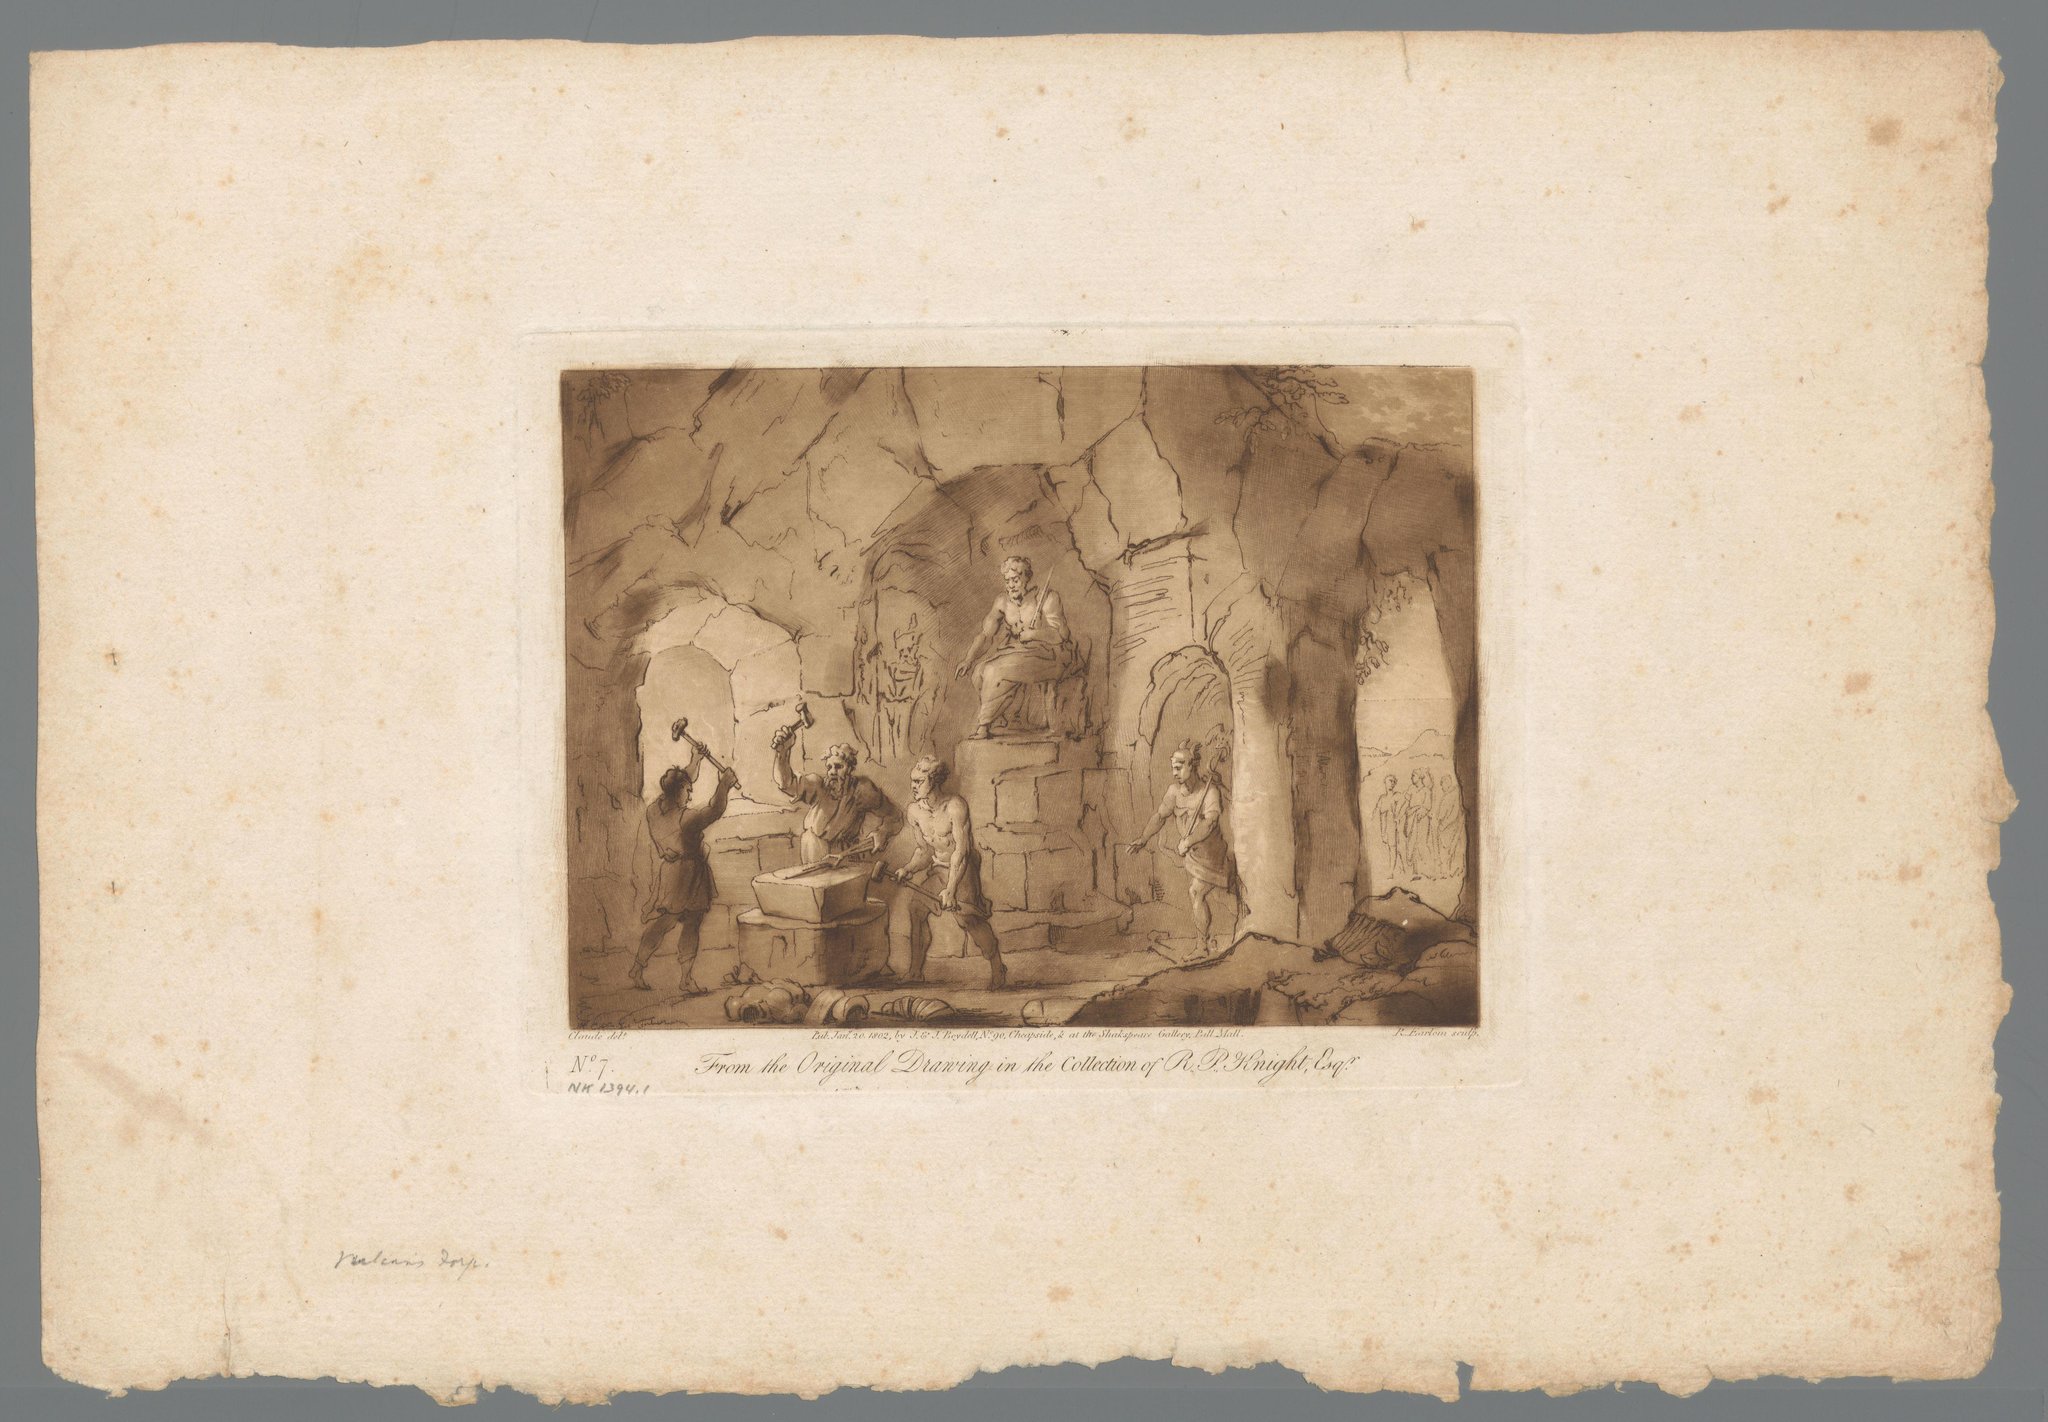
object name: print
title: Vulcanus smeedt een bliksemschicht voor Jupiter, terwijl hij toekijkt en Mercurius aan komt lopen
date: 1802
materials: paper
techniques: etching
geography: england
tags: (story of) mercury (hermes), vulcan forging jupiter's thunderbolt, (story of) jupiter (zeus), cave, grotto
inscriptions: stamp: ‘foto’, collector's mark: Lugt 2228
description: De prent werd in 1819 nogmaals gebonden uitgegeven: Earlom, Richard. Liber Veritatis; or A Collection of Prints, after the Original Designs of Claude le Lorrain (...). Londen: Hurst, Robinson & Co., 1819.